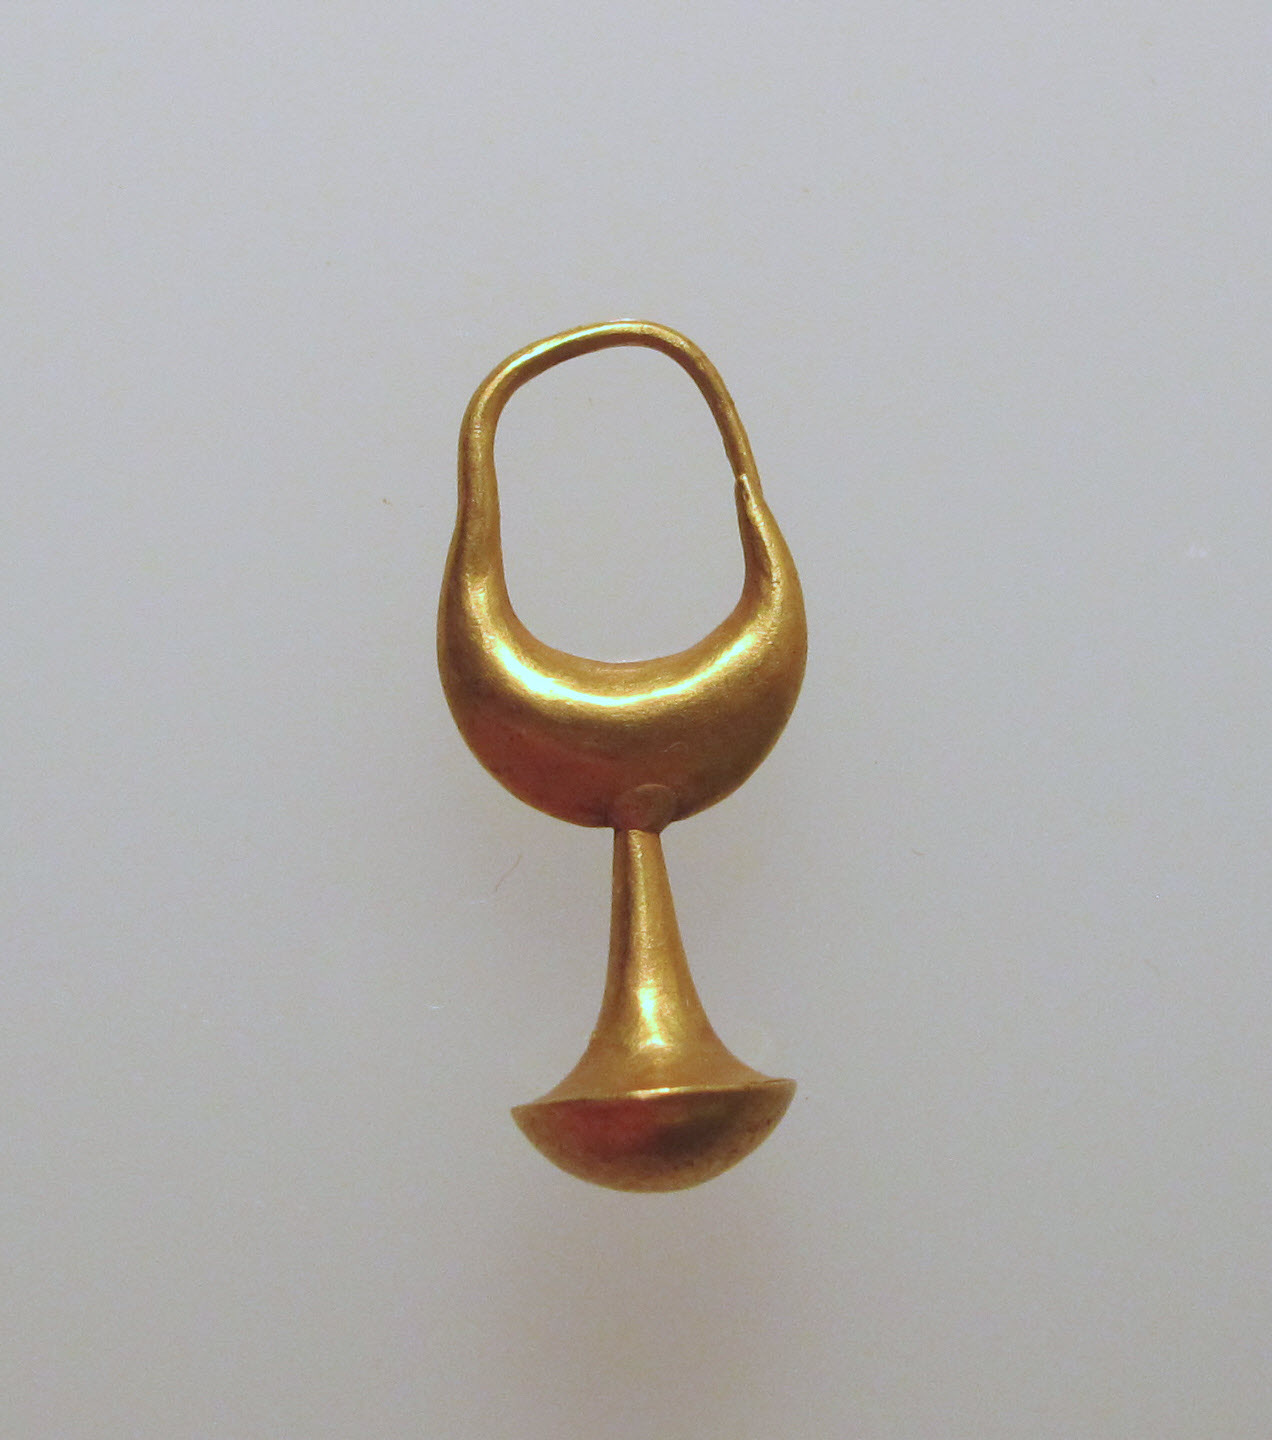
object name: earring with nail head pendant, 12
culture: cypriot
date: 3900 BCE-100 CE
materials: gold